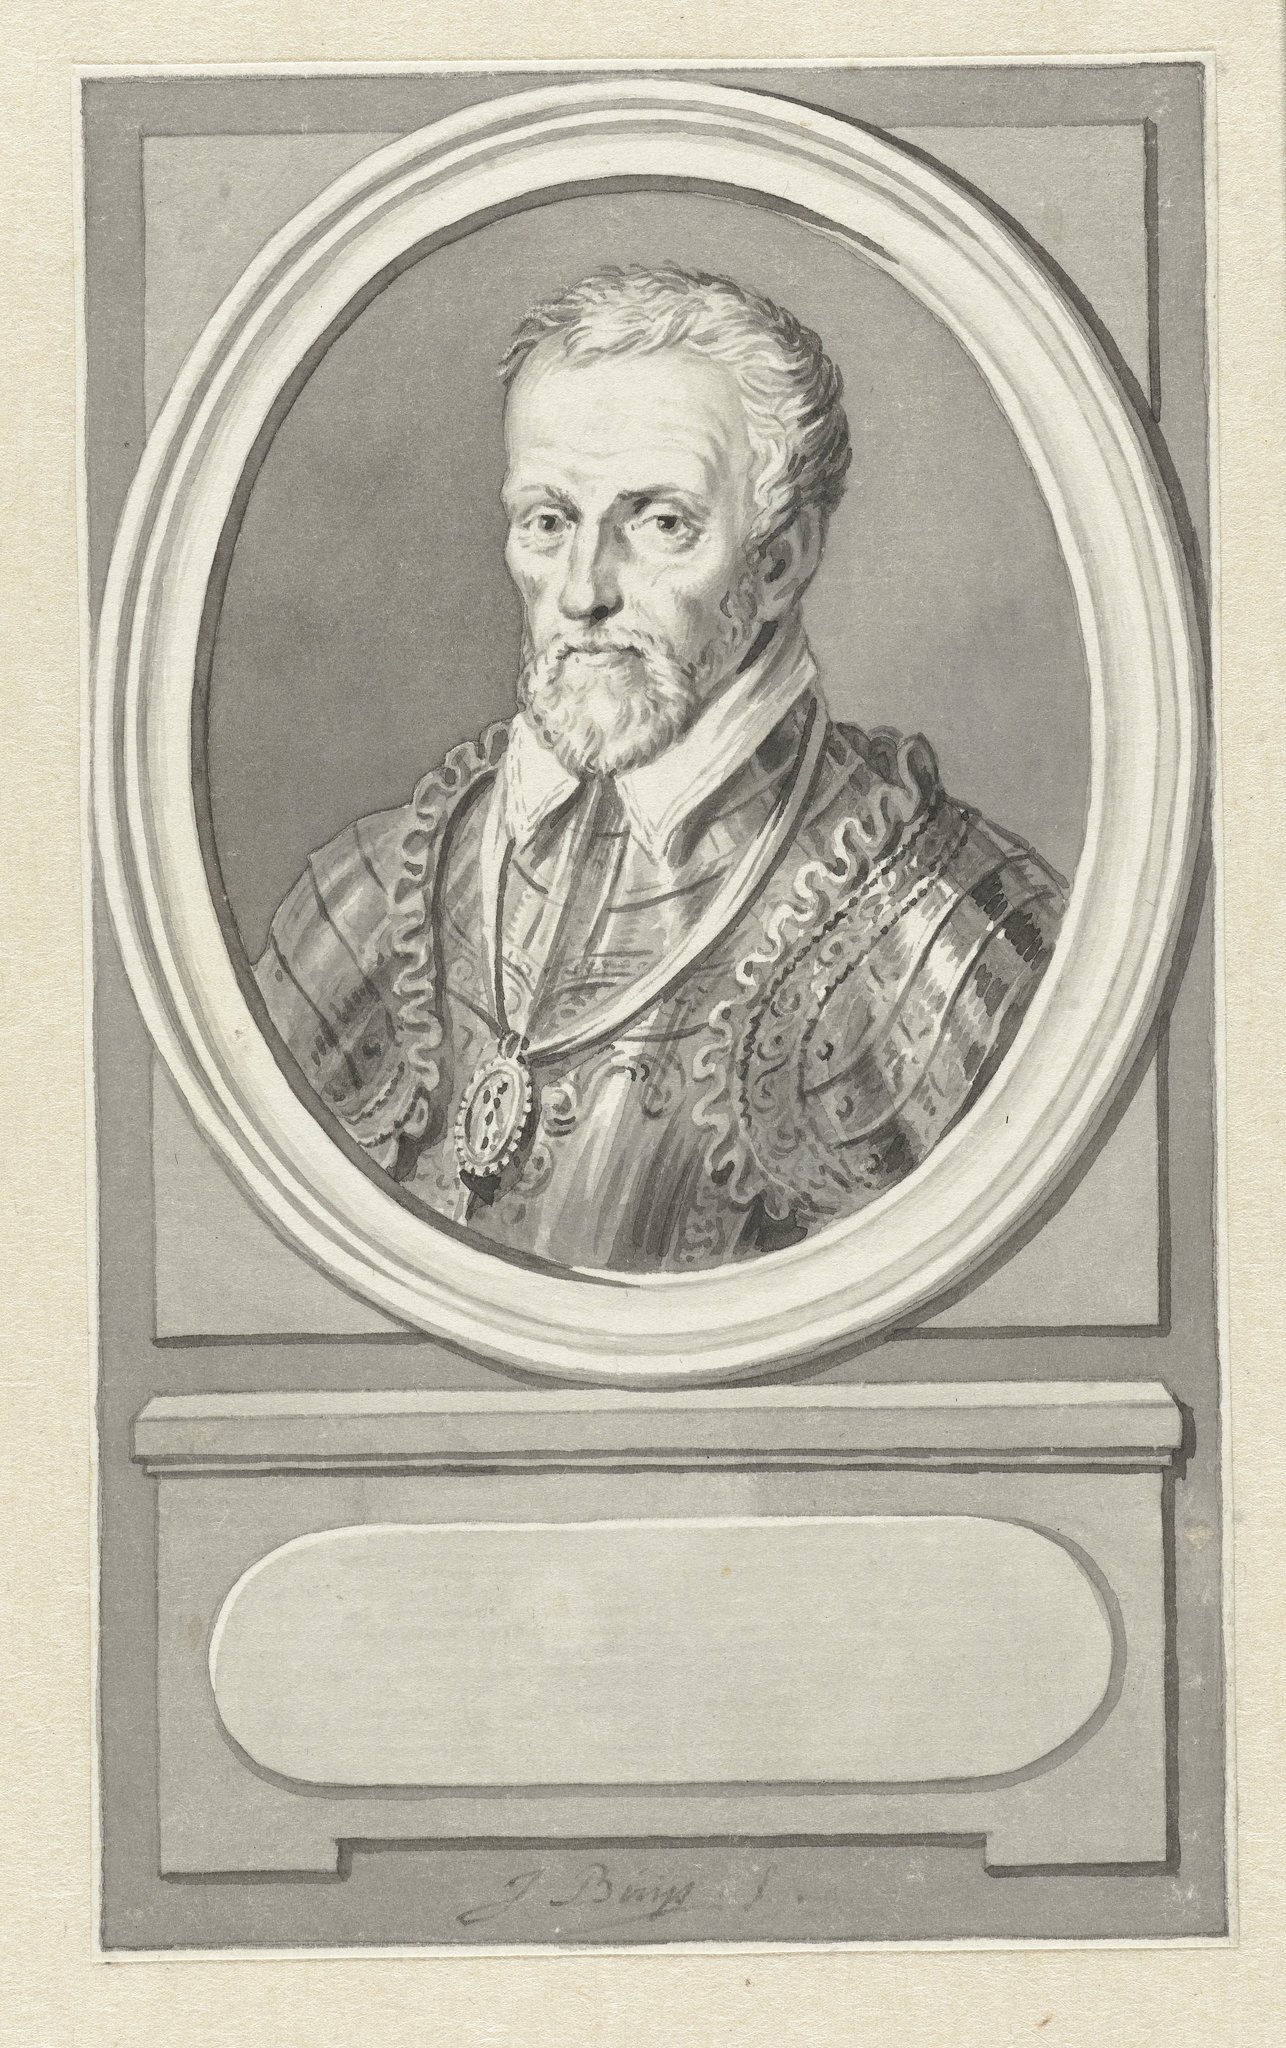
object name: drawing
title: Portret van Gaspard de Coligny II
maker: jacobus buys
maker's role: draughtsman, print maker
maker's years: 1724-1801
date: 1734-1801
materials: ink, paper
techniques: brush, pen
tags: paris, politician, gaspard de coligny (ii), historical persons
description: Portret van Gaspard de Coligny, admiraal van Frankrijk. Ontwerp voor een prent.